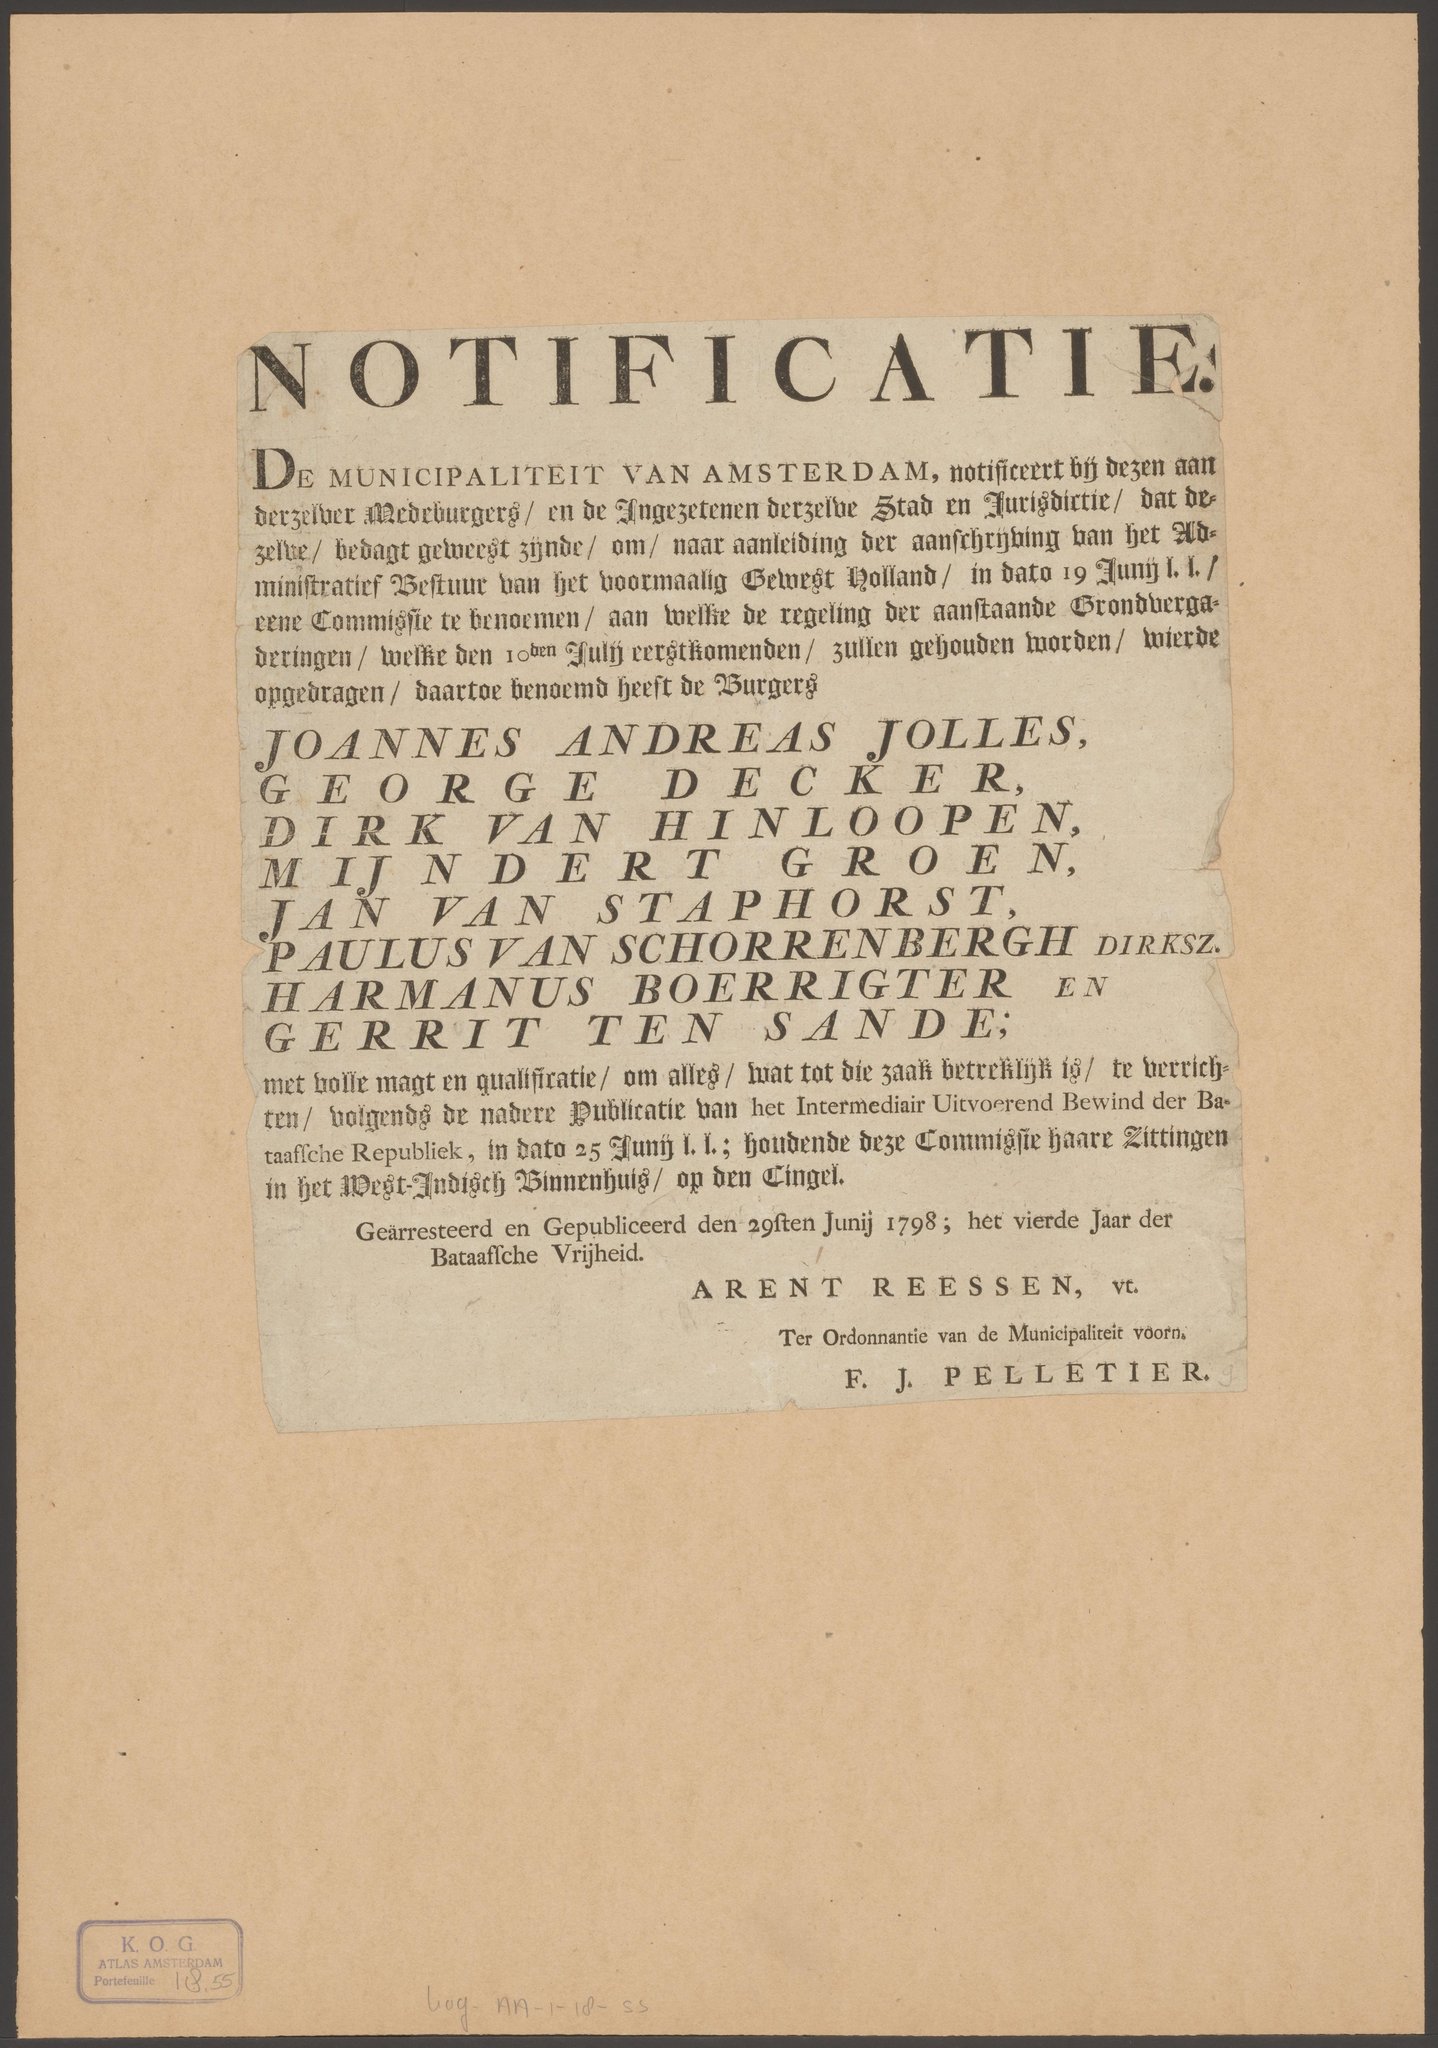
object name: text sheet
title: Benoeming van een nieuwe commissie die vergaderingen van de regering moet controleren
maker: Anonymous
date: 1798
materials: paper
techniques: letterpress printing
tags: municipal government, amsterdam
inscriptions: collector's mark: ‘18.55’ Lugt 1641b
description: Onderwerpsrubriek binnen de Atlas Amsterdam: Herinneringen aan regeringsleden en hunne huisgezinnen [voor 1800].